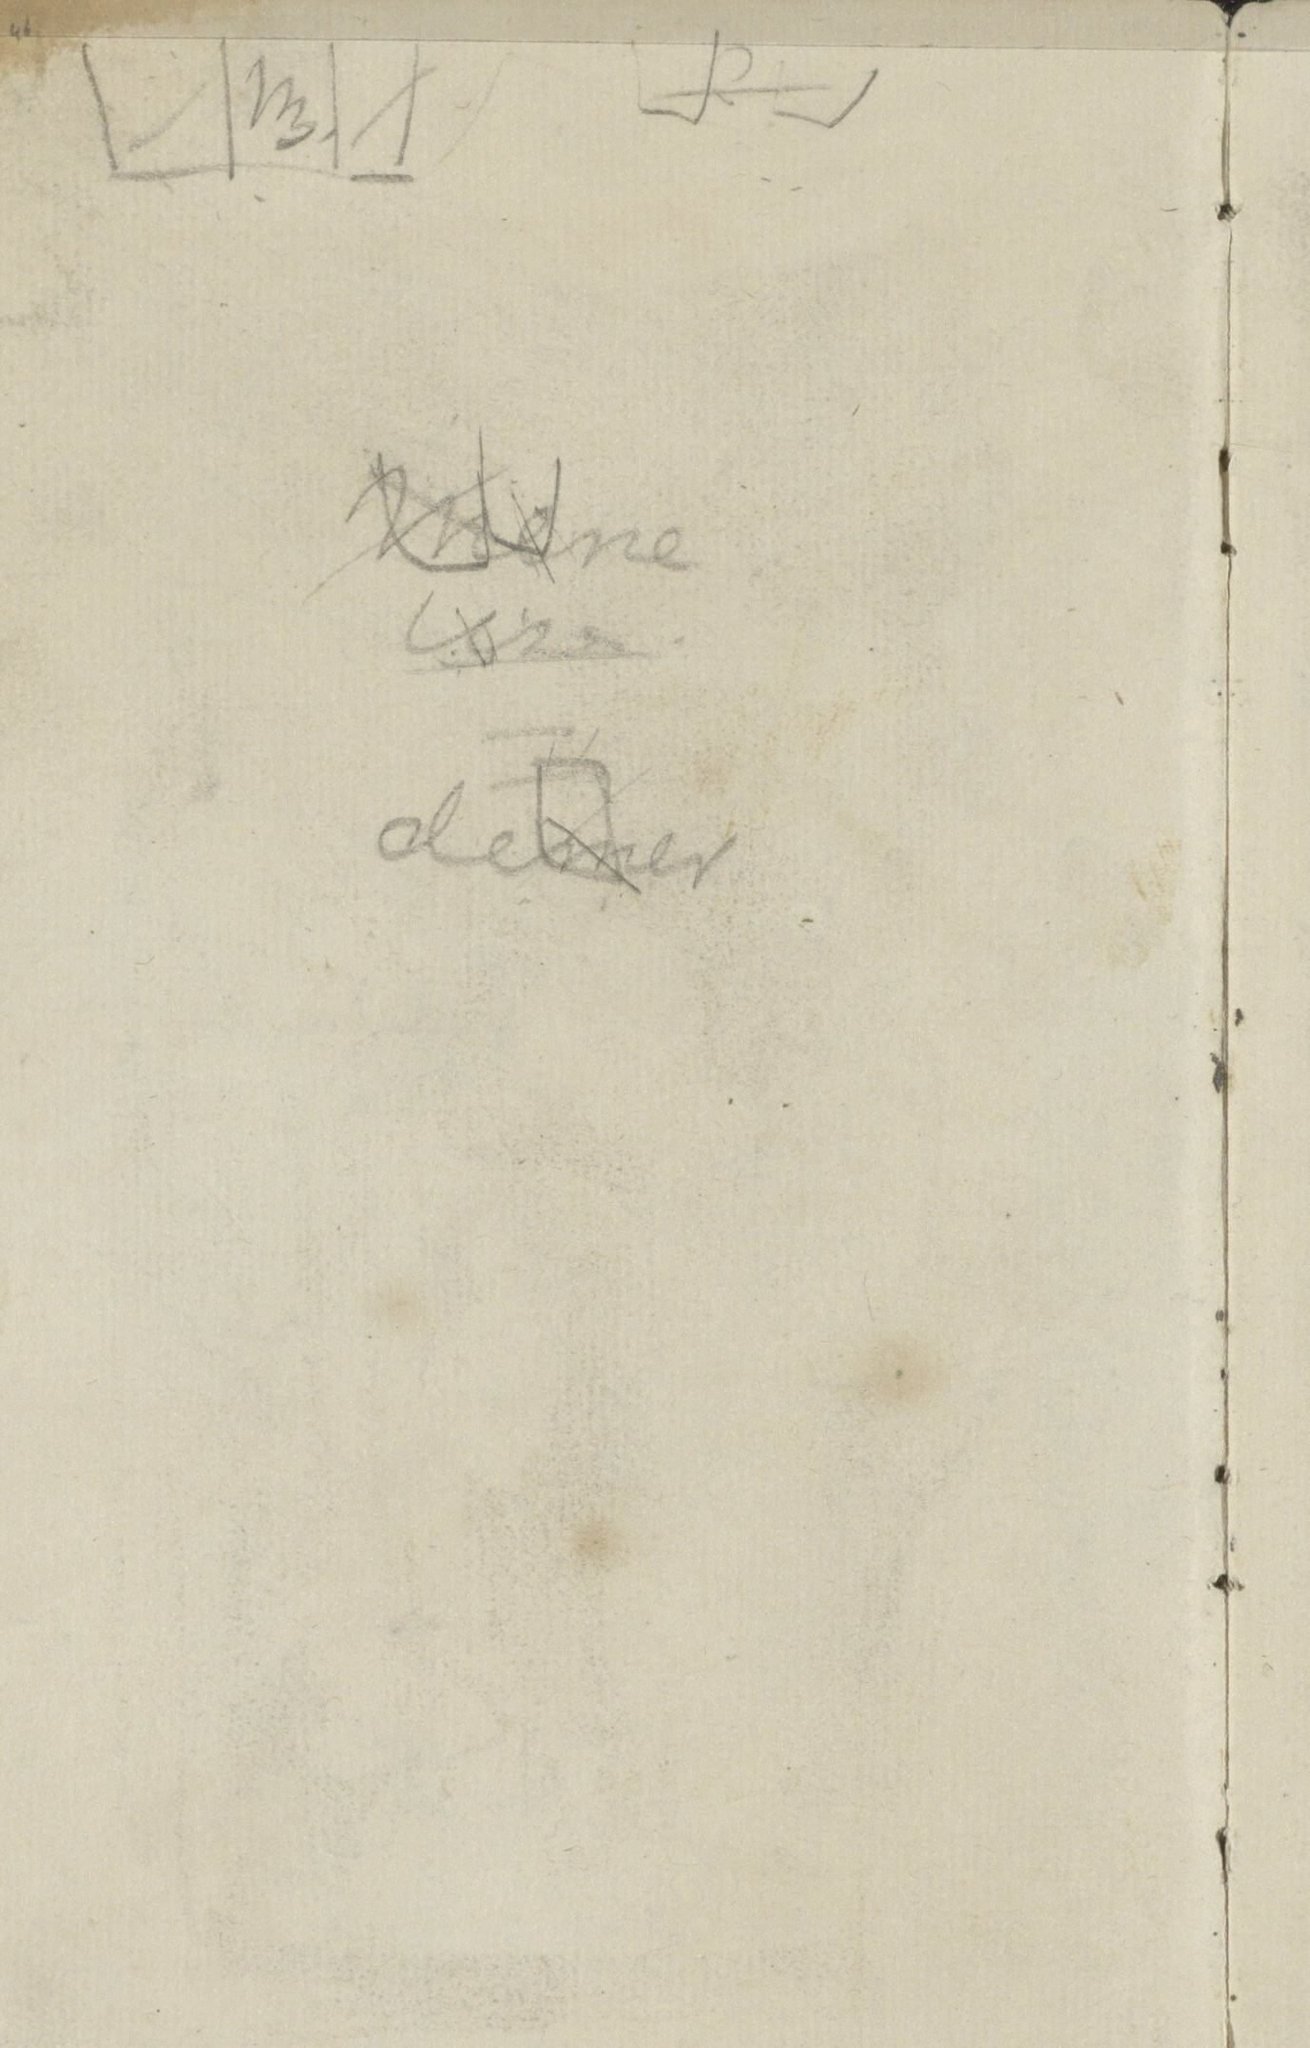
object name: sketchbook leaf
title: Annotaties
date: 1881-1883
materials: paper, pencil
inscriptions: annotation: ‘[...]’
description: Pagina 46 uit een schetsboek met 29 bladen.